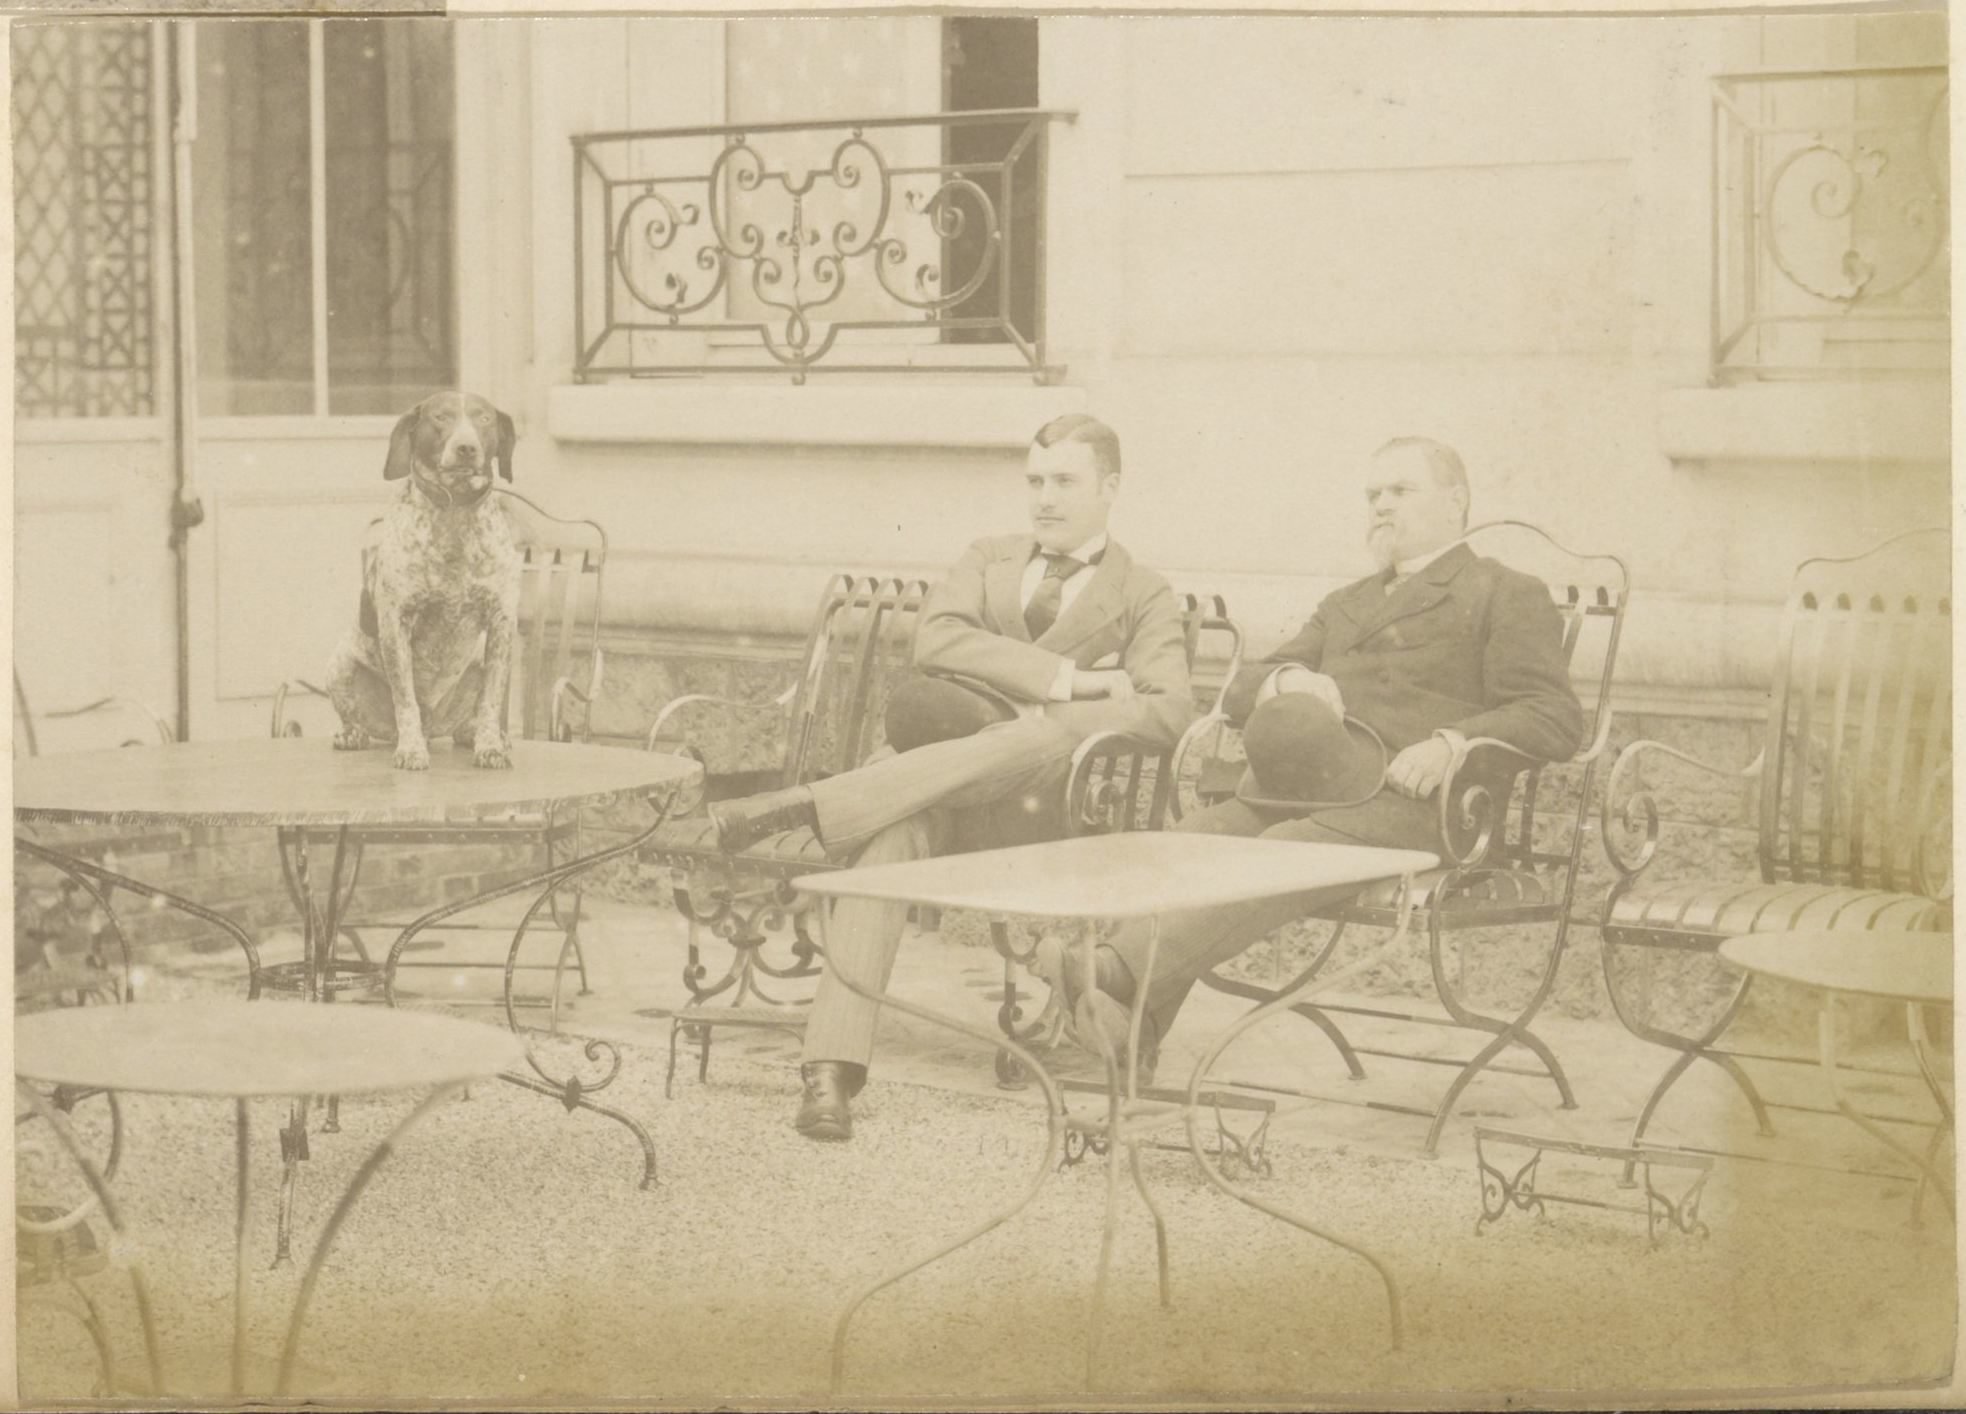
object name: photograph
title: Twee mannen en een hond in een tuin in Frankrijk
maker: Anonymous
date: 1900-1910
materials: paper, photographic support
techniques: albumen print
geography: france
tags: armchair, seat, garden, adult man, dog, france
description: Onderdeel van Fotoalbum van een Franse amateurfotograaf met opnames van een familie, distilleerderij Delizy & Doistau Fils, het leger en bezienswaardigheden in Frankrijk.